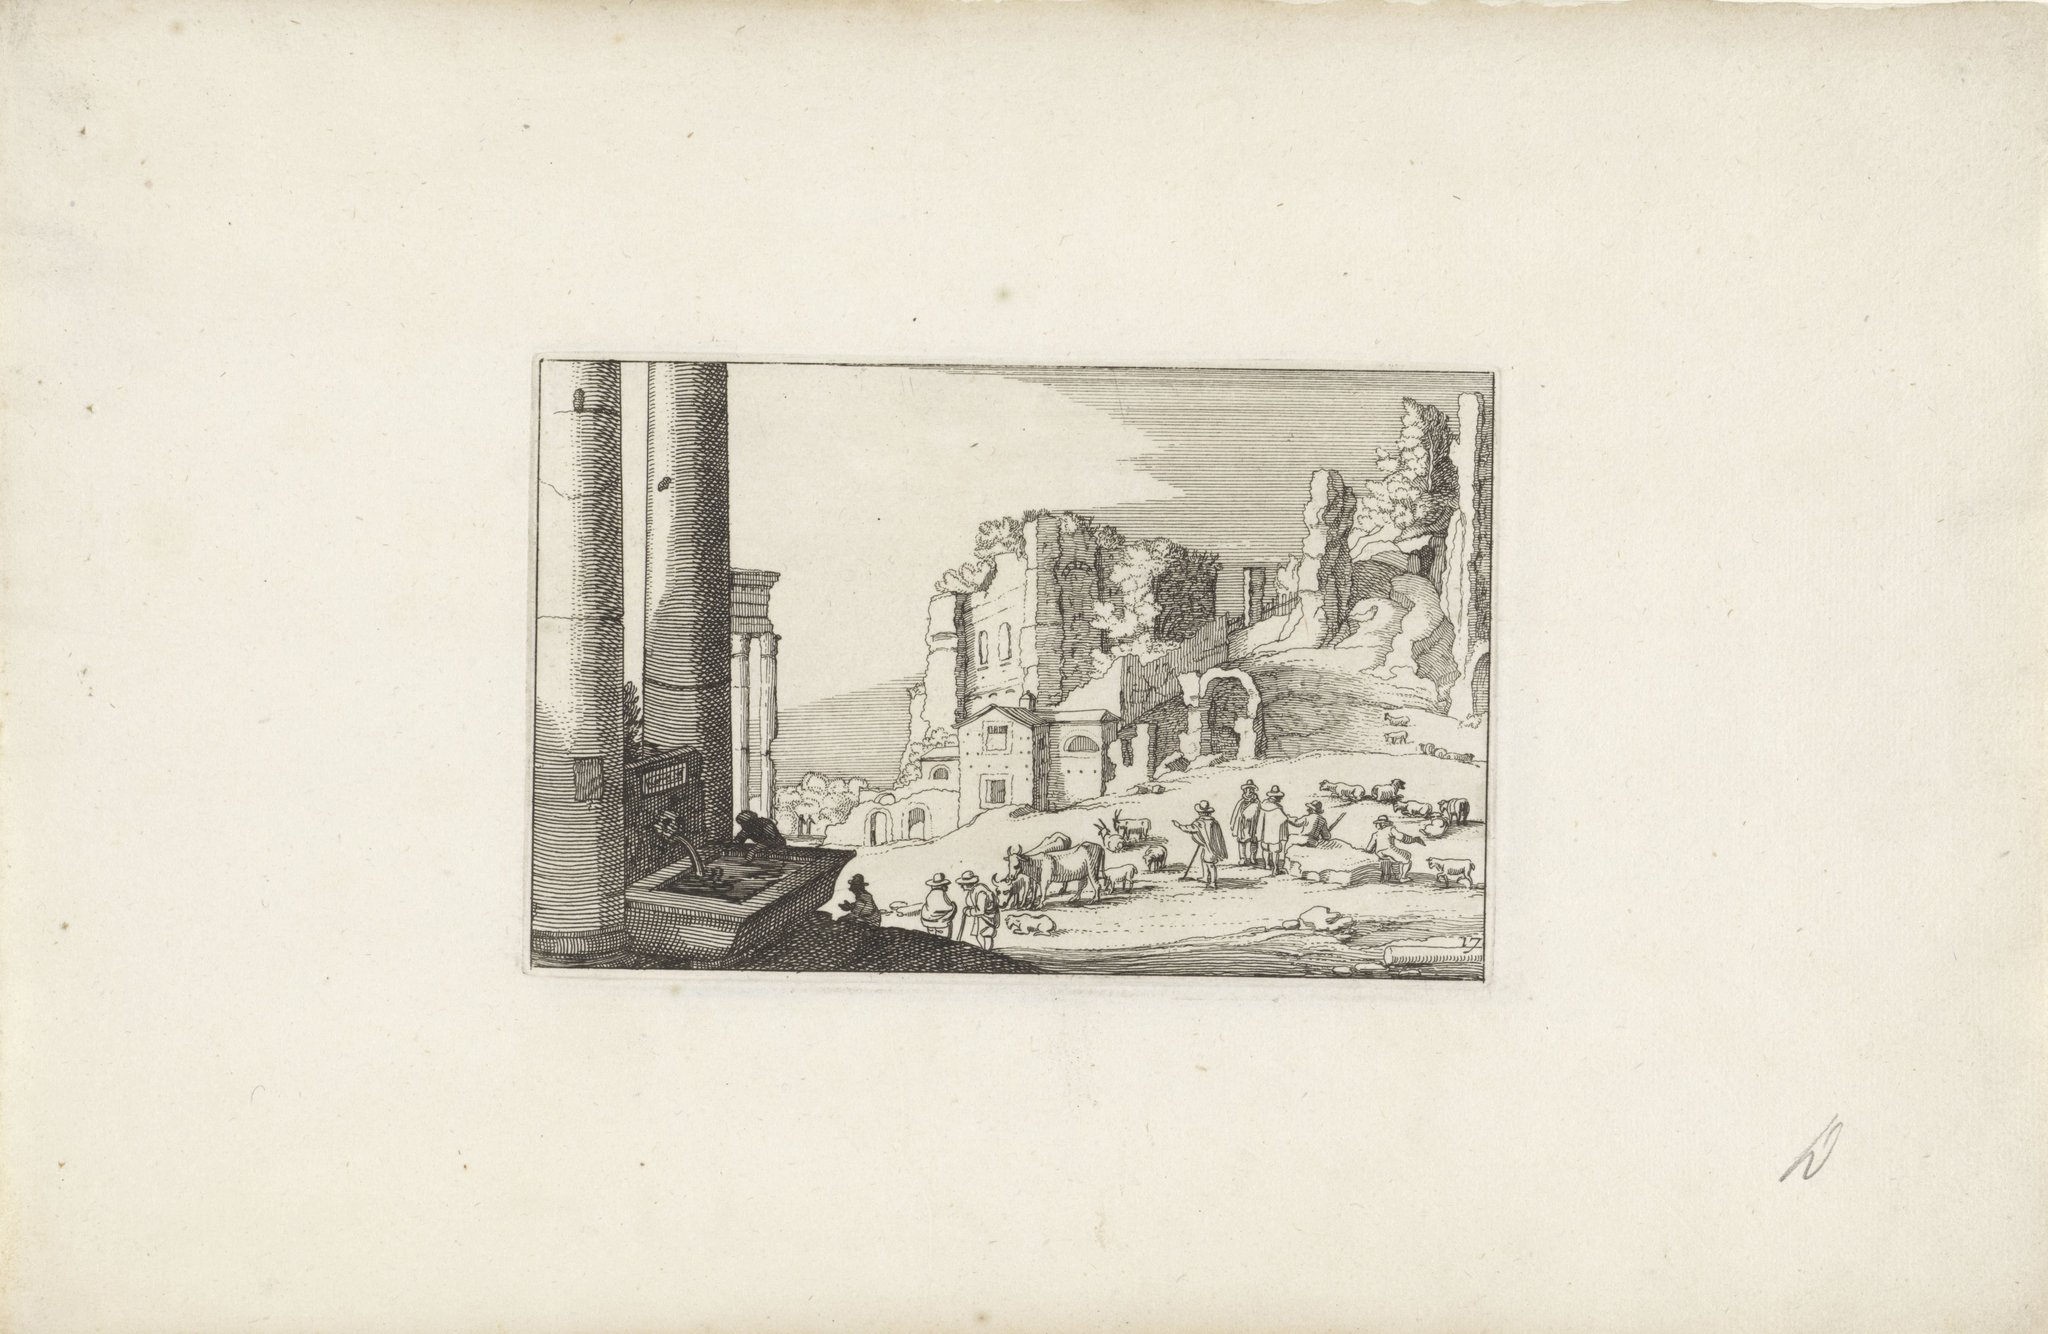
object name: print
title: Variae antiquitates Romanae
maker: claes jansz. visscher (ii)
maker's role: draughtsman, print maker, publisher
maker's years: 1586-1652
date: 1618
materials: paper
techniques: etching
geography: amsterdam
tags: herding, herdsman, herdswoman, shepherd, shepherdess, cowherd, etc., landscape with ruins, ornamental fountain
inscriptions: collector's mark: Lugt 2233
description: Gezicht op een heuvellandschap met op de voorgrond een fontein tussen twee zuilen. Op de heuvel staan herders met hun vee en op de achtergrond zijn huizen te zien.